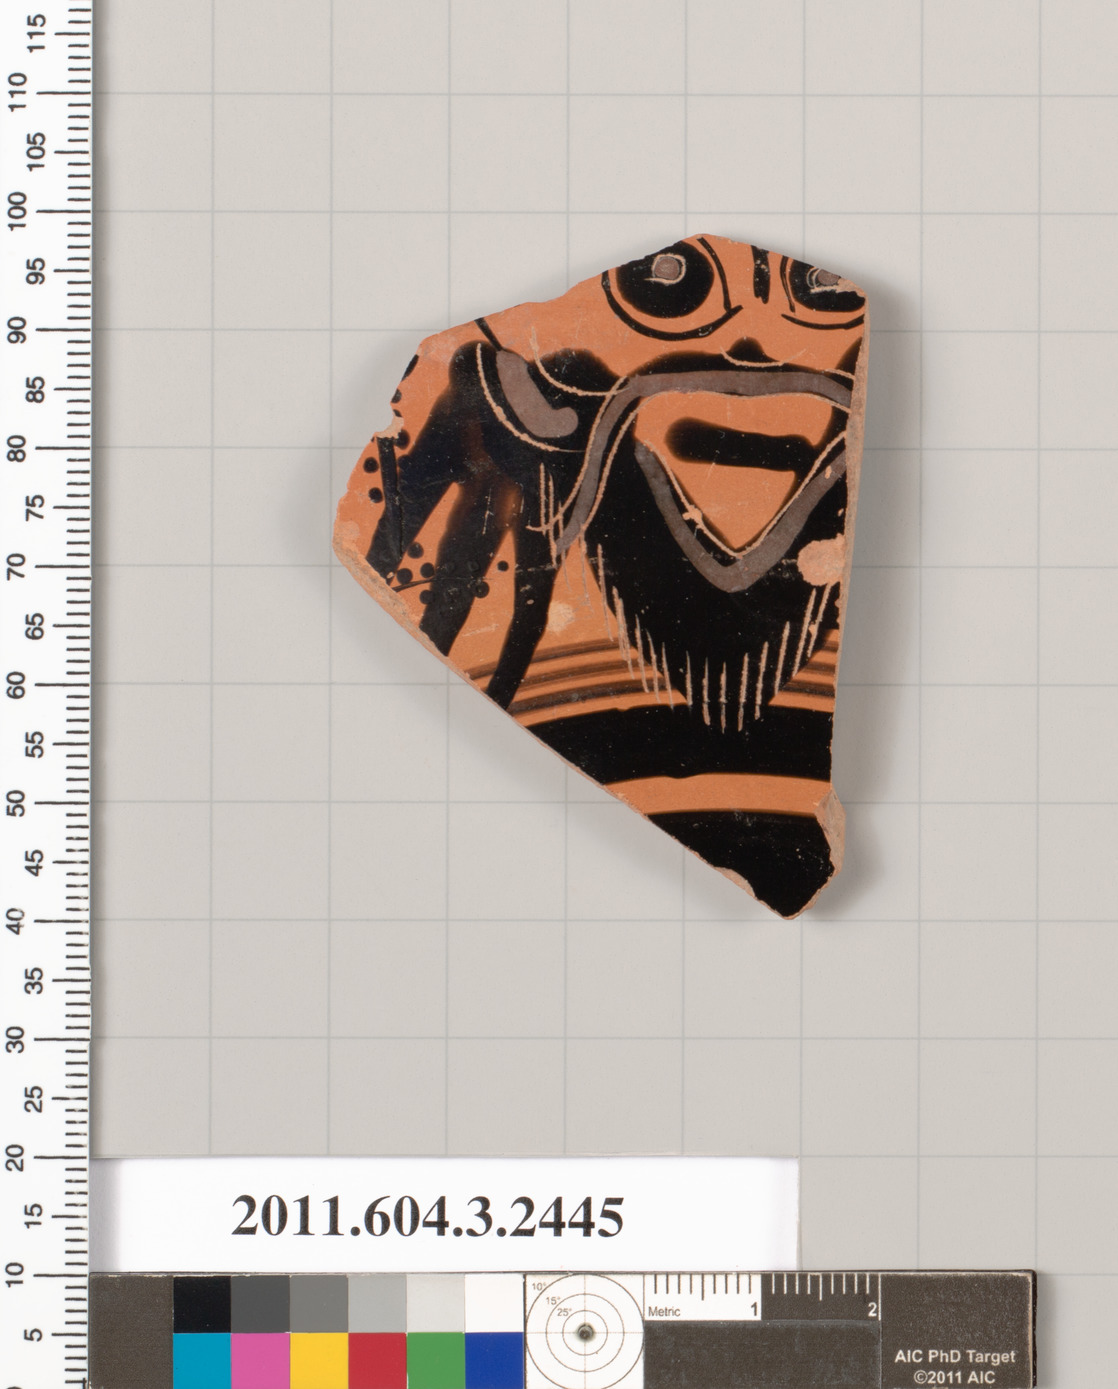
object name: kylix fragment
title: Terracotta fragment of a kylix: eye-cup (drinking cup)?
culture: greek, attic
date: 525-501 BCE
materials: terracotta